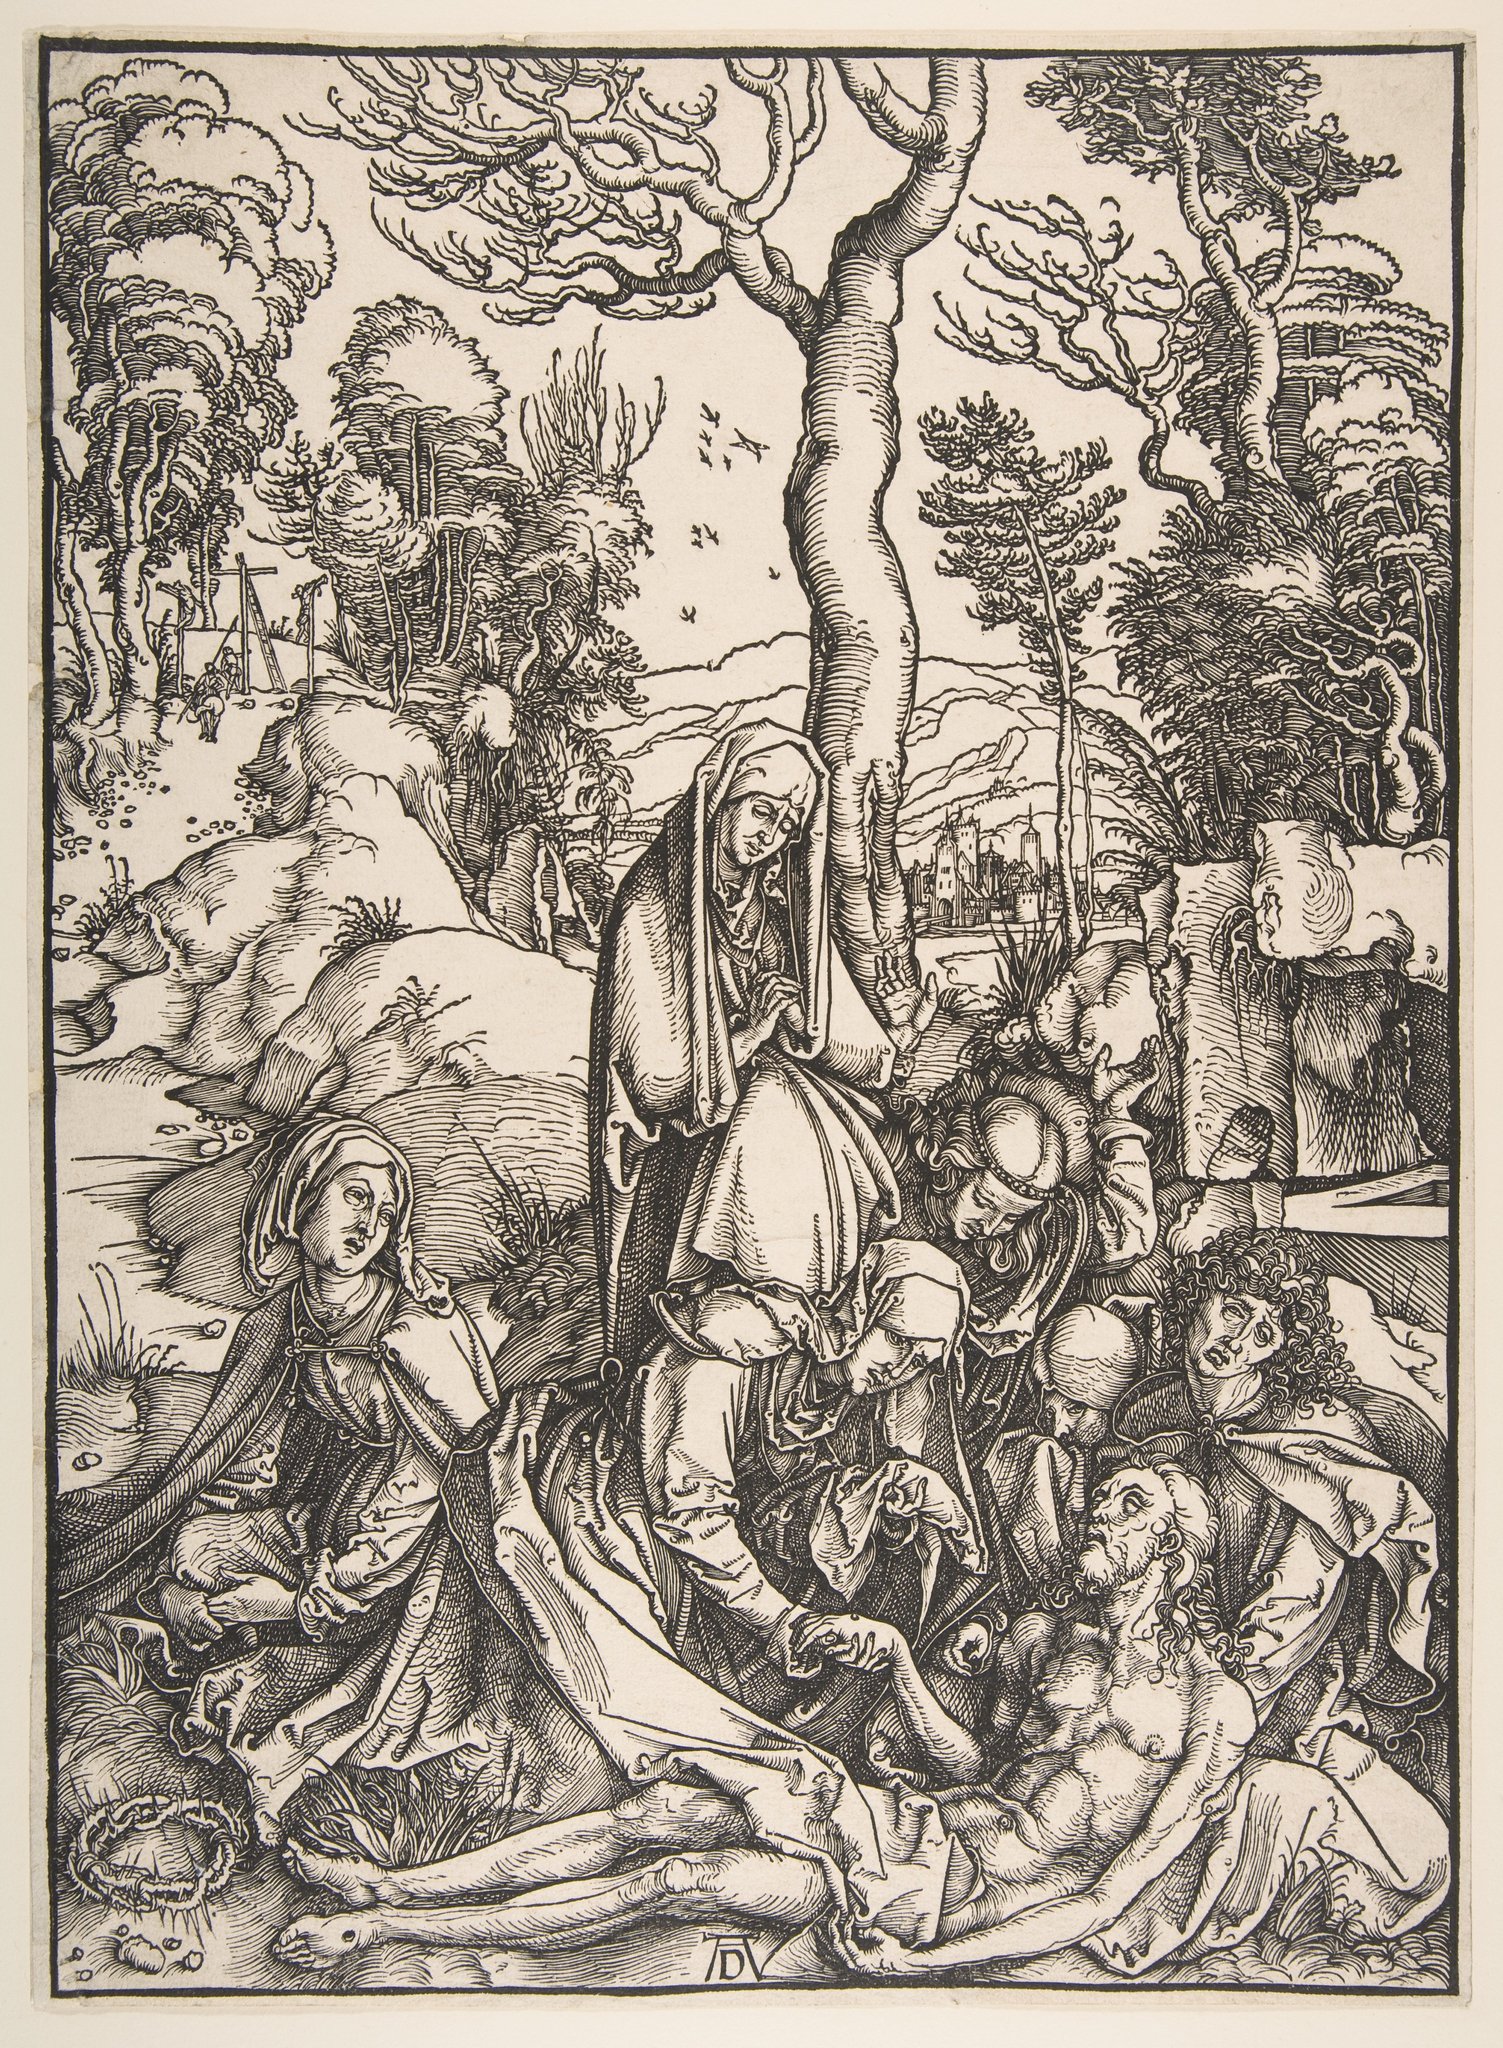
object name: print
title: The Lamentation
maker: albrecht dürer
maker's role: artist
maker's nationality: german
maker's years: 1471-1528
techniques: woodcut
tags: jesus,lamentation